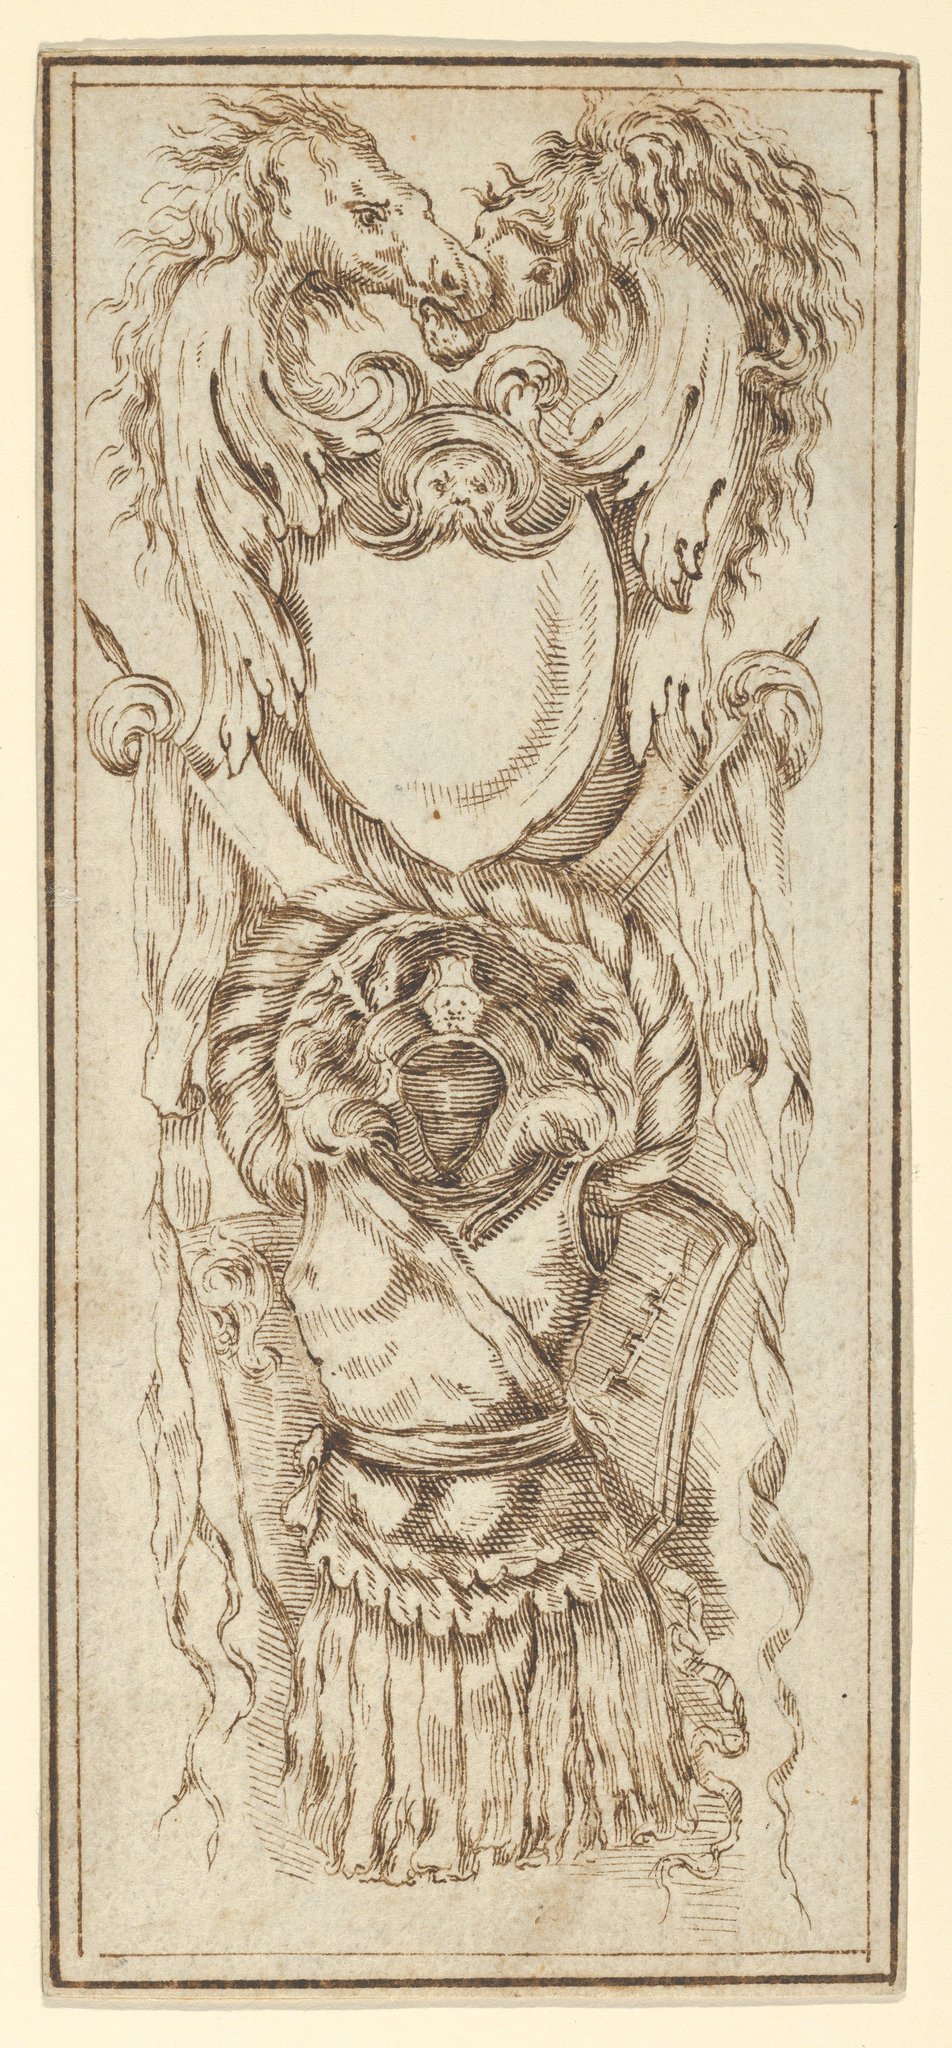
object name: drawing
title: Ornament with Armor and Horses' Heads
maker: stefano della bella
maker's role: artist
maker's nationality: italian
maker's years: 1610-1664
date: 1601-1700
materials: ink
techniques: pen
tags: armor,horses